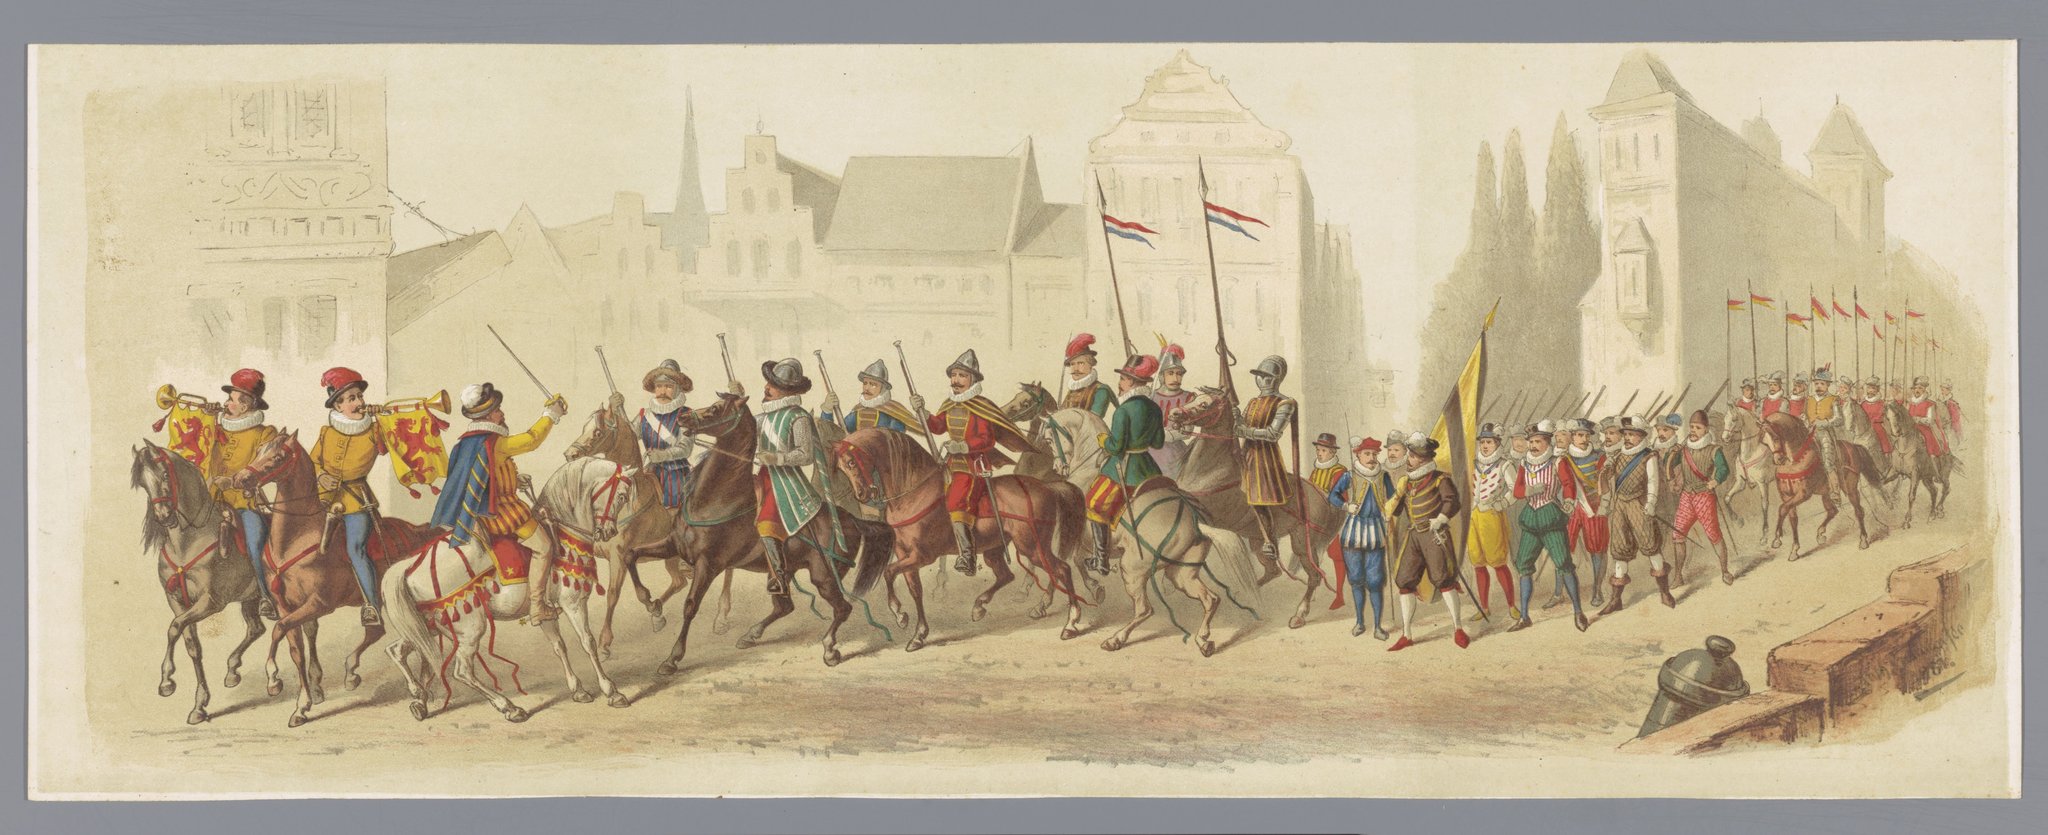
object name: print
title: Utrechtse maskerade van 1881 (zevende plaat)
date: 1881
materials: paper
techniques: chromolithography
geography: utrecht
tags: vienna, matthias van oostenrijk (rooms-duits keizer), students' pageant, costumes used in pageants, commemoration of the founding of a university, utrecht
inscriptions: collector's mark: Lugt 2228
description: Zevende plaat met een deel van de optocht. Onderdeel van de serie van zeven platen plus titelprent en verklaring van de gekostumeerde optocht door de studenten van de Utrechtse Hogeschool op 28 juni 1881 bij de viering van het 245-jarig bestaan van de Hogeschool. Voorgesteld is de intocht van aartshertog Matthias in Brusssel op 18 januari 1578.